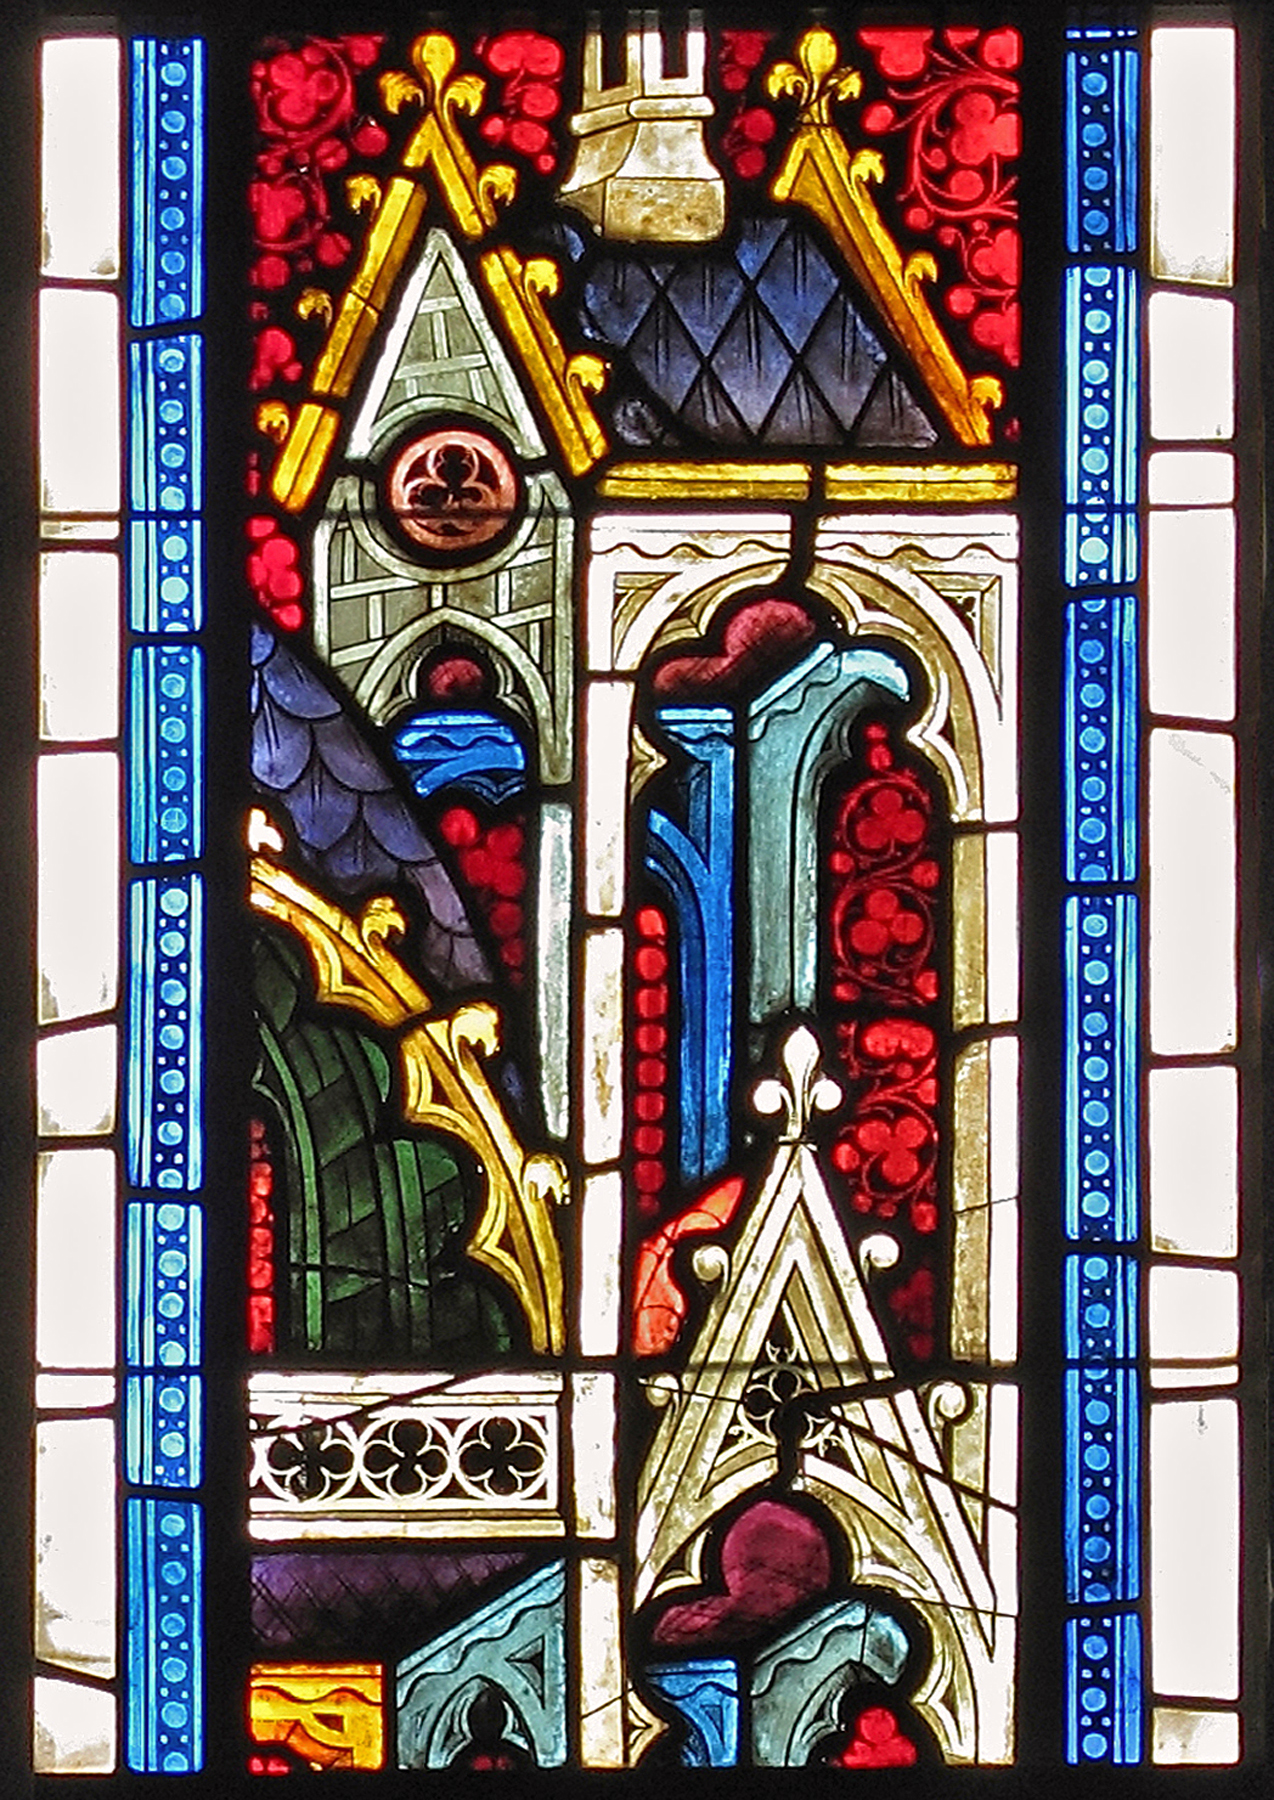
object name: panel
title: Architectural canopy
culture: austrian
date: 1390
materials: glass, metal, paint, pigment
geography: austria